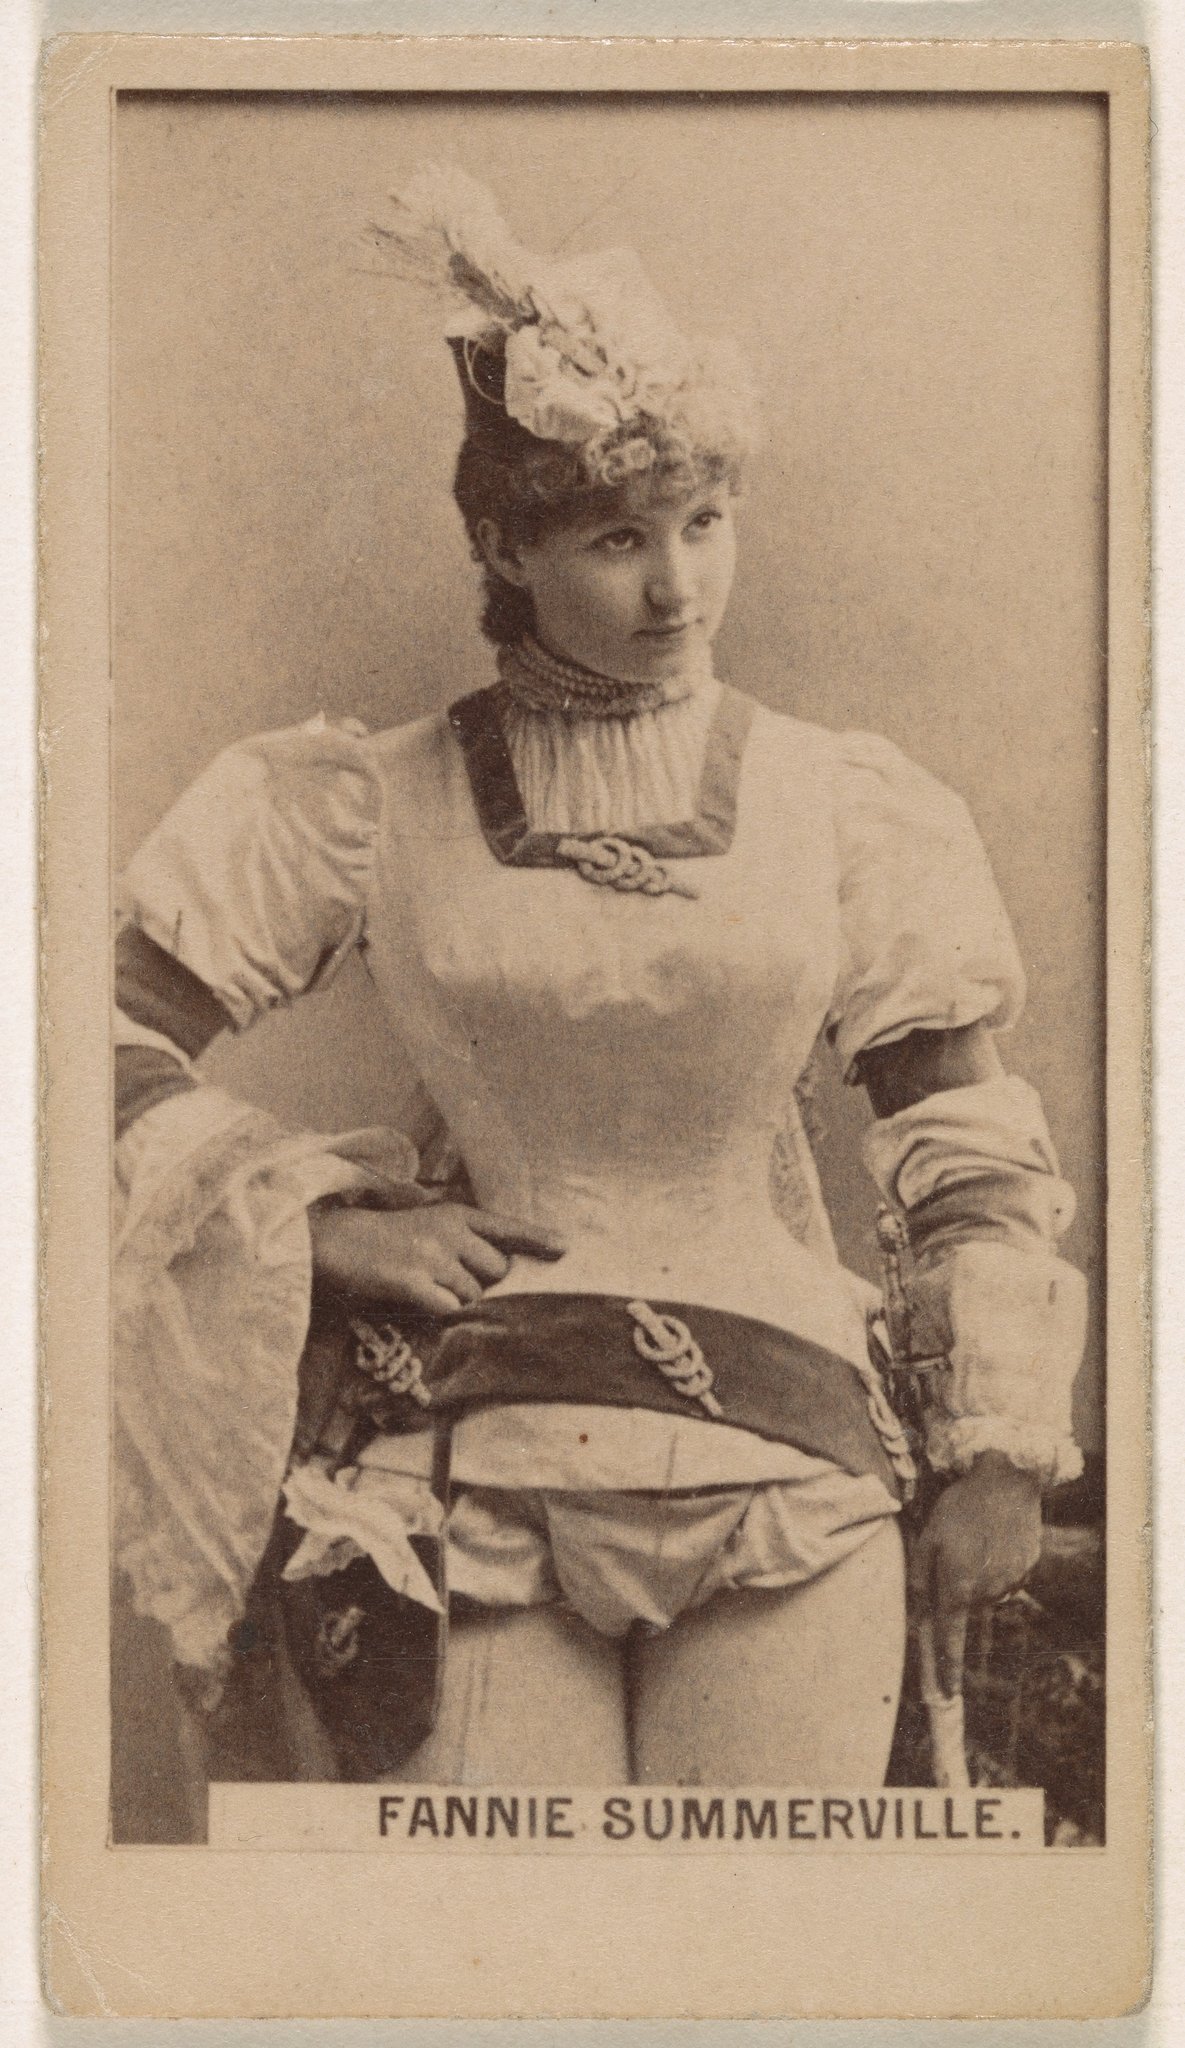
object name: photograph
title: Miss Fannie Summerville, from the Actresses series (N245) issued by Kinney Brothers to promote Sweet Caporal Cigarettes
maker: kinney brothers tobacco company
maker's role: publisher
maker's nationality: american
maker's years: 1869-2011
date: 1890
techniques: albumen silver print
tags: portraits,women,actresses